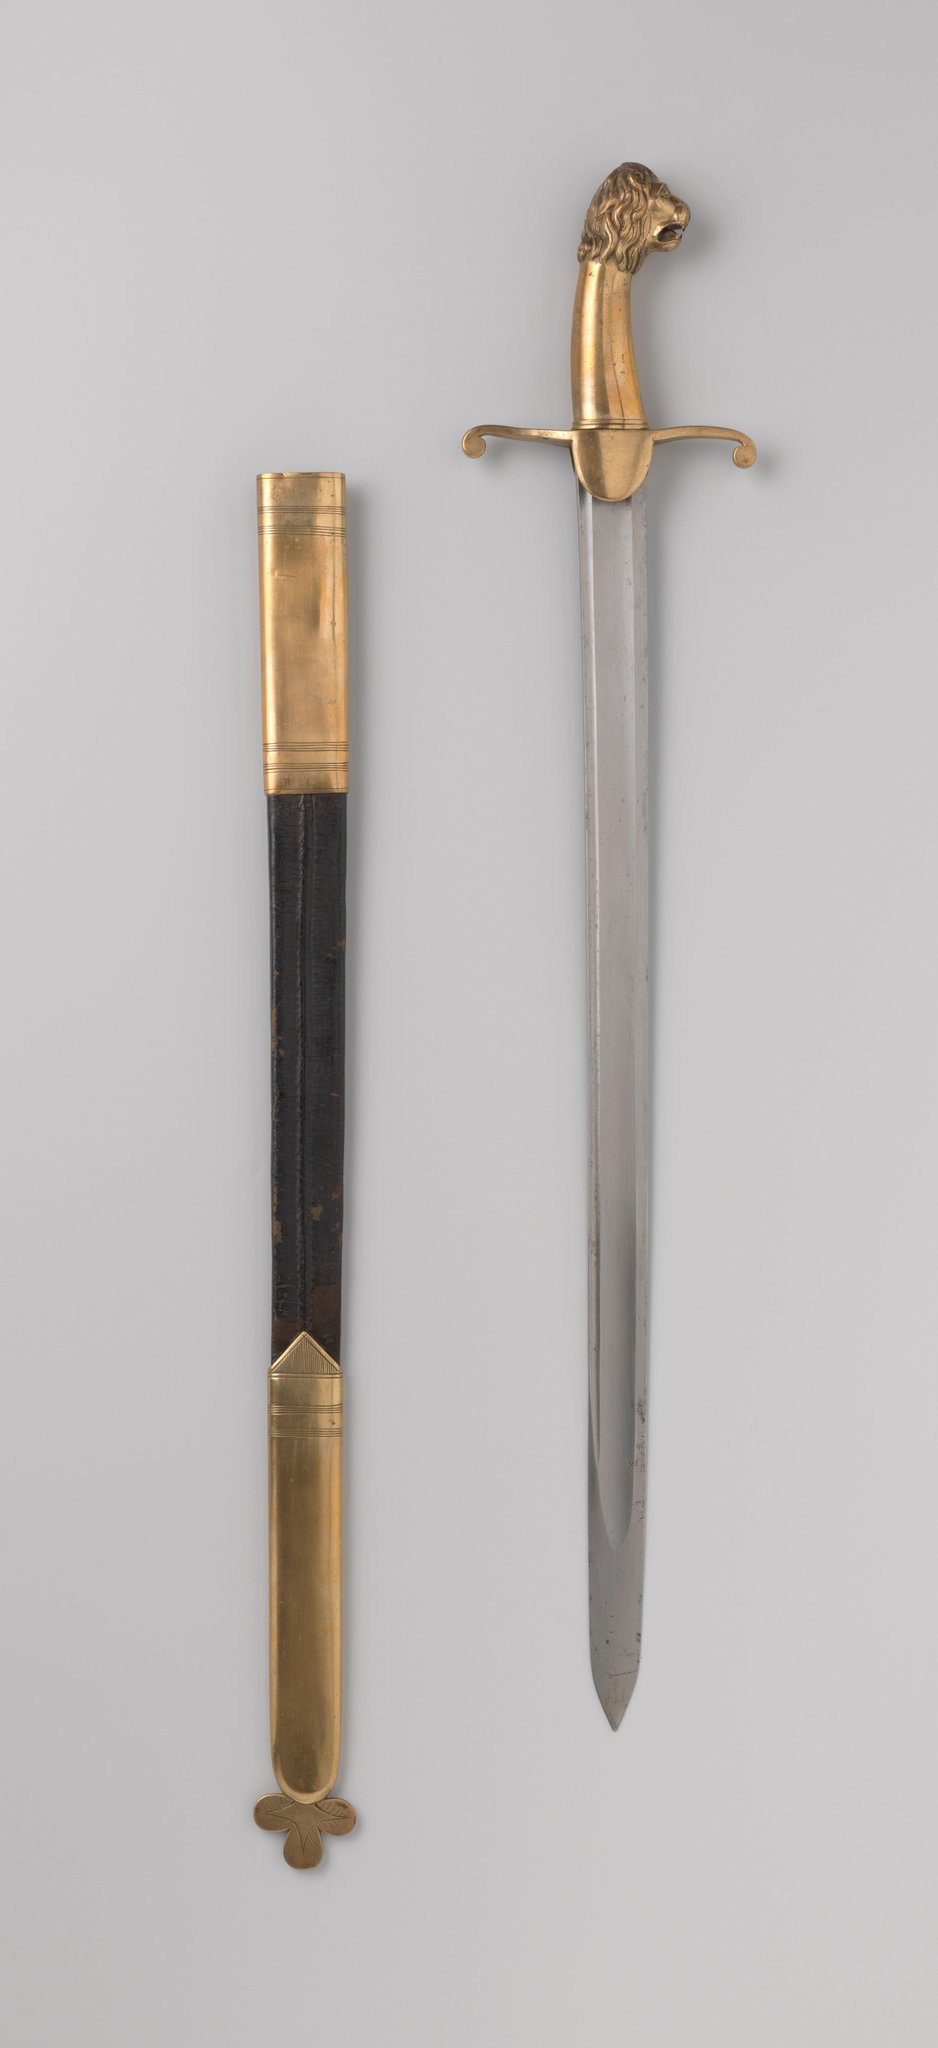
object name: sabre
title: Sabel van tamboer-majoor.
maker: Anonymous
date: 1800-1899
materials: brass, iron, leather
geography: netherlands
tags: netherlands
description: Sabel van een tamboer-majoor met leren schede. Het gevest van de sabel is uit één stuk gegoten en geheel van messing. De greepkap is een gebogen leeuwenkop die zich op de gladde greep bevindt. De pareerstang is aan beide zijden neerwaarts gekruld met schijfknoppen. In het midden van de pareestang een halfovaal neerwaarts wijzend pareerhart. De kling is recht met een brede bloedgeul. De schede is van leer met messing beslag. Op de mondingsband een schildvormige ophangknop. De sleepplaat heeft de vorm van een klaverblad.